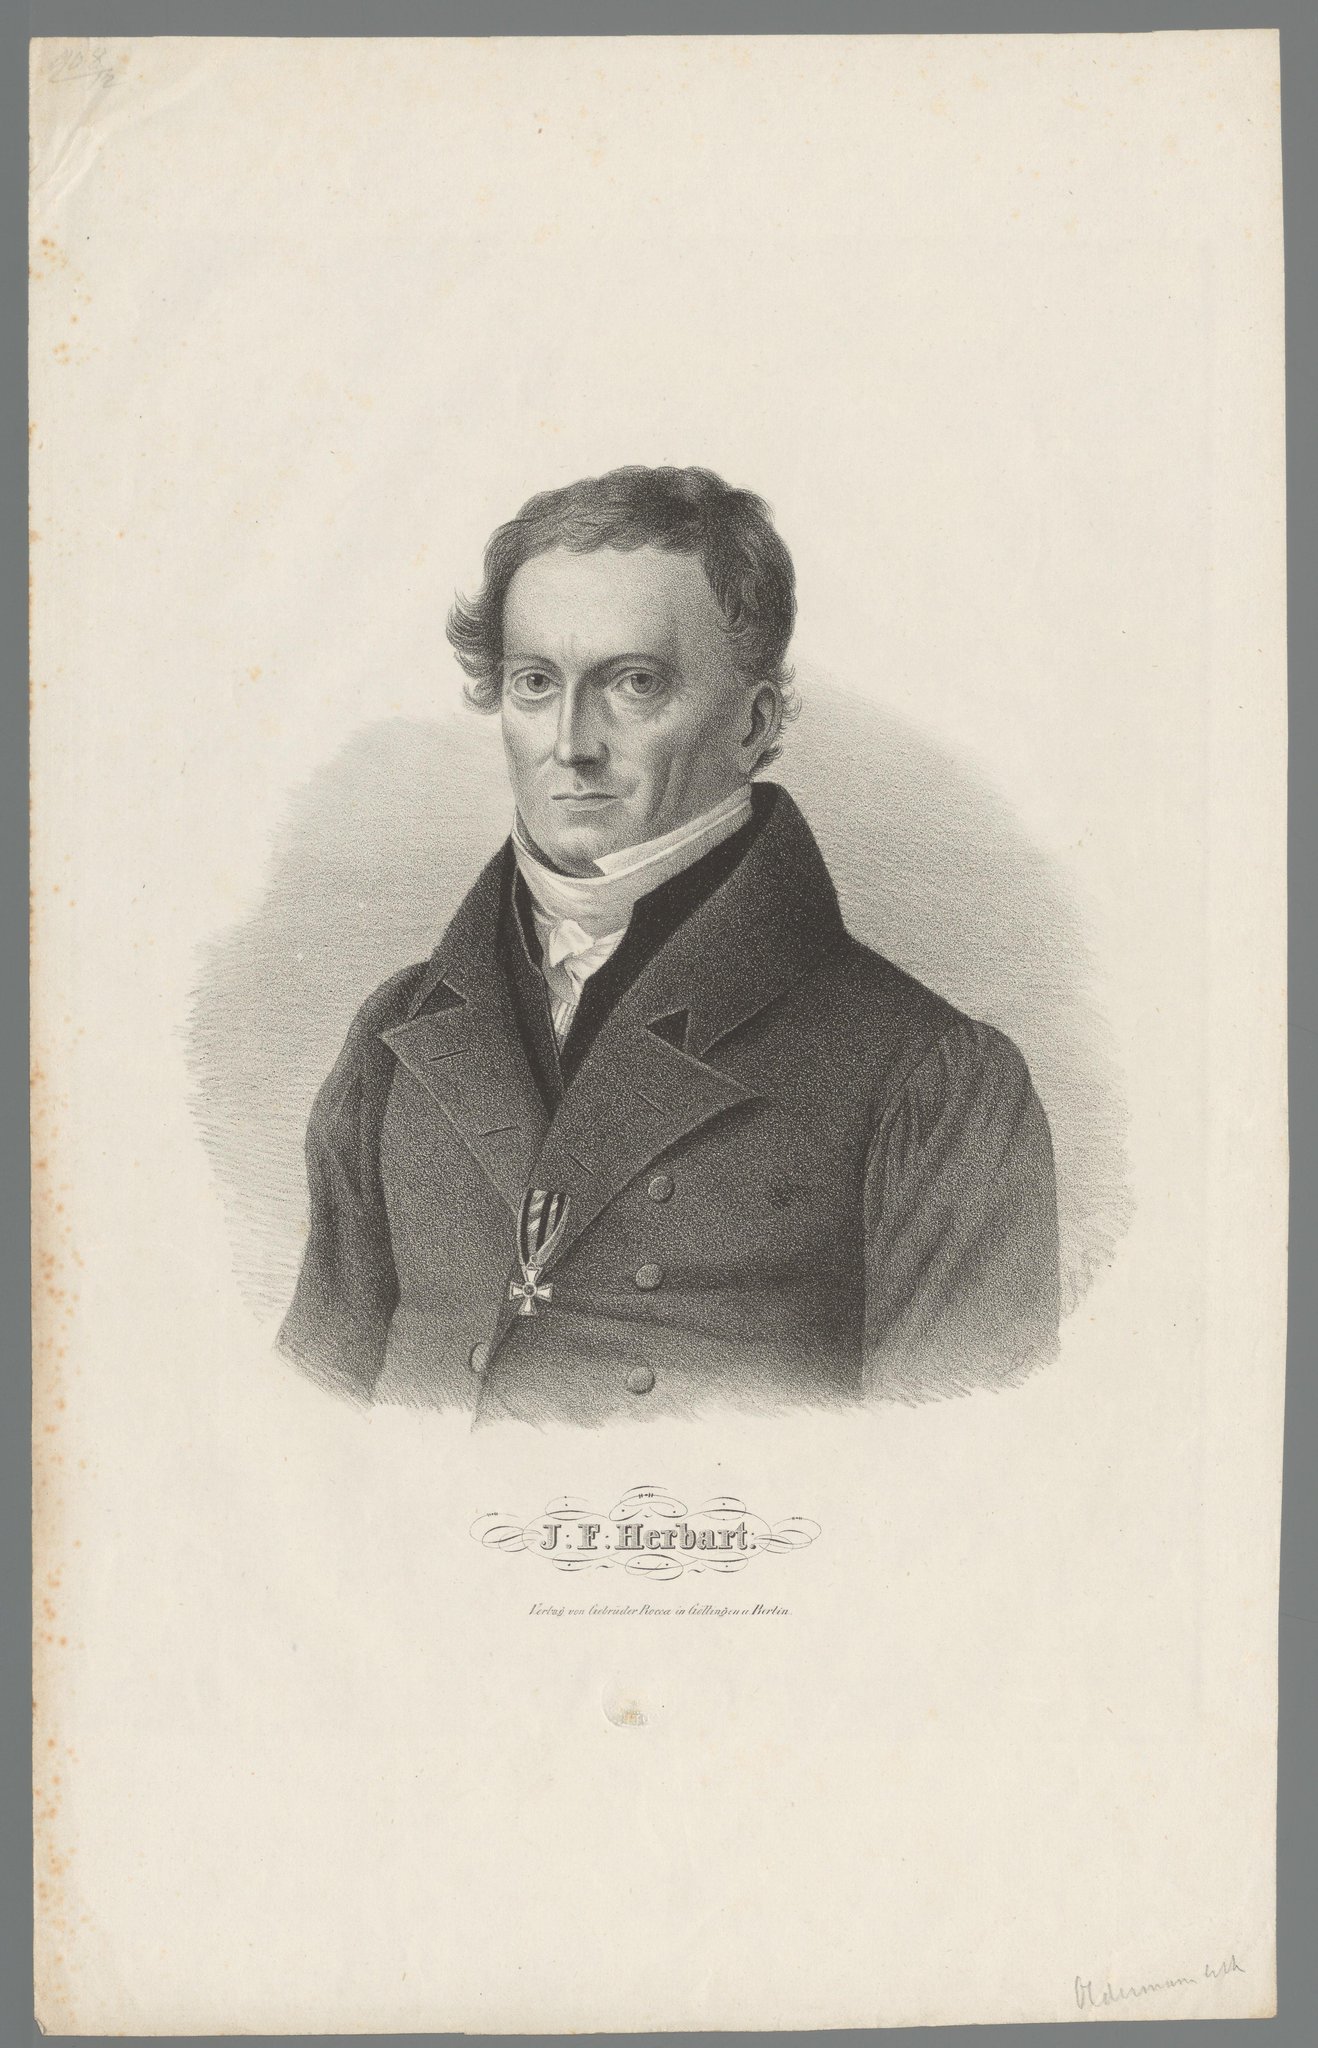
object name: print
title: Portret van Johann Friedrich Herbart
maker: ernst friedrich oldermann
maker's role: print maker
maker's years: 1802-1874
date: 1812-1874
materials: paper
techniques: lithograph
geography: gottingen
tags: adult man, historical persons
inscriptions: check stamp: ‘Rocca [...] in Göttingen [...]’, collector's mark: Lugt 2228